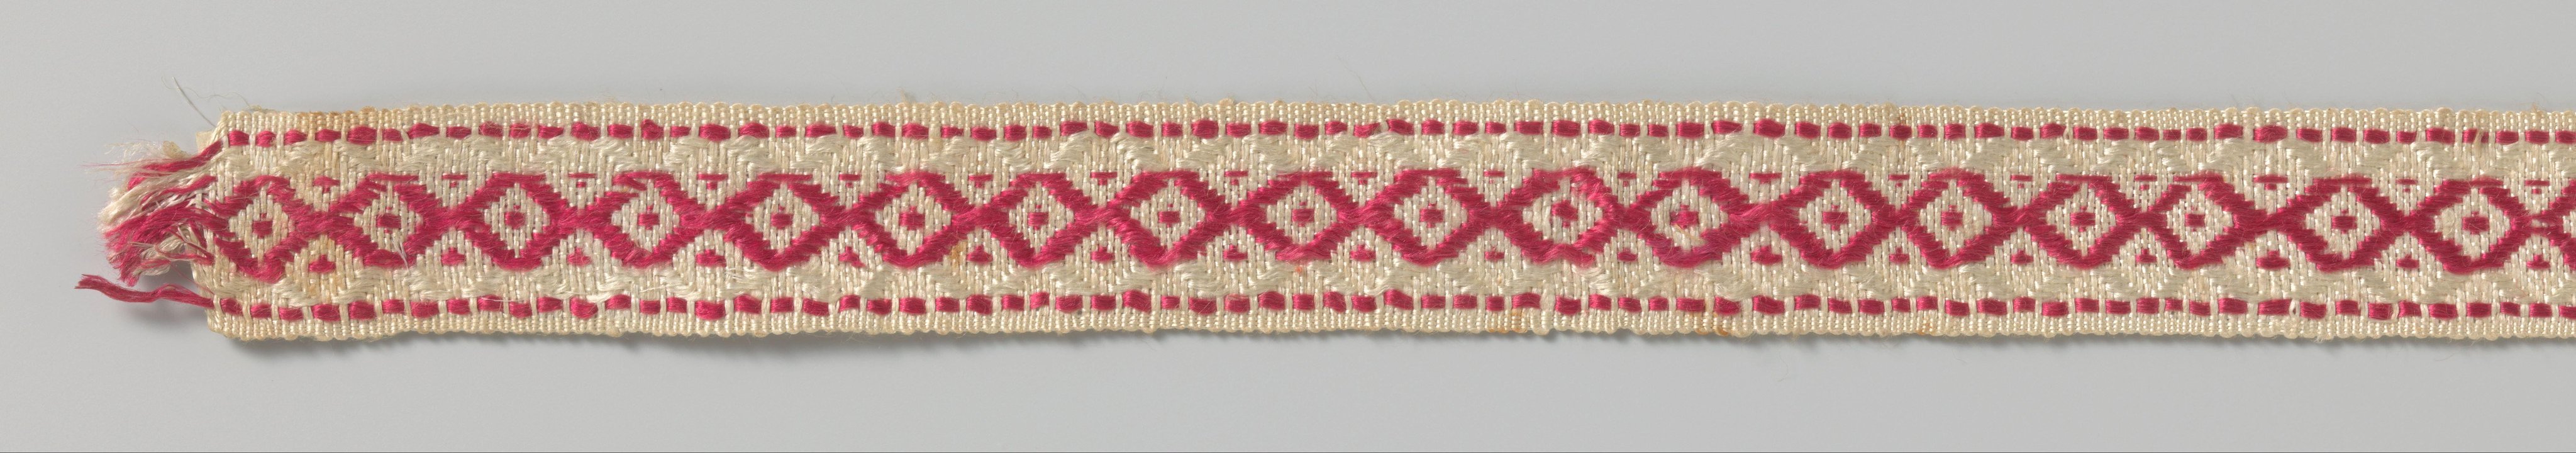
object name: ribbon material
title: Lint van zijde, met ruit- en stippatroon in rood en wit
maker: Anonymous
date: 1700-1894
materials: silk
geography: western europe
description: Lint van zijde, met ruit- en stippatroon in rood en wit. Mogelijk een langet of langittenband, gebruikt als omboording van de Hindeloper wentke.